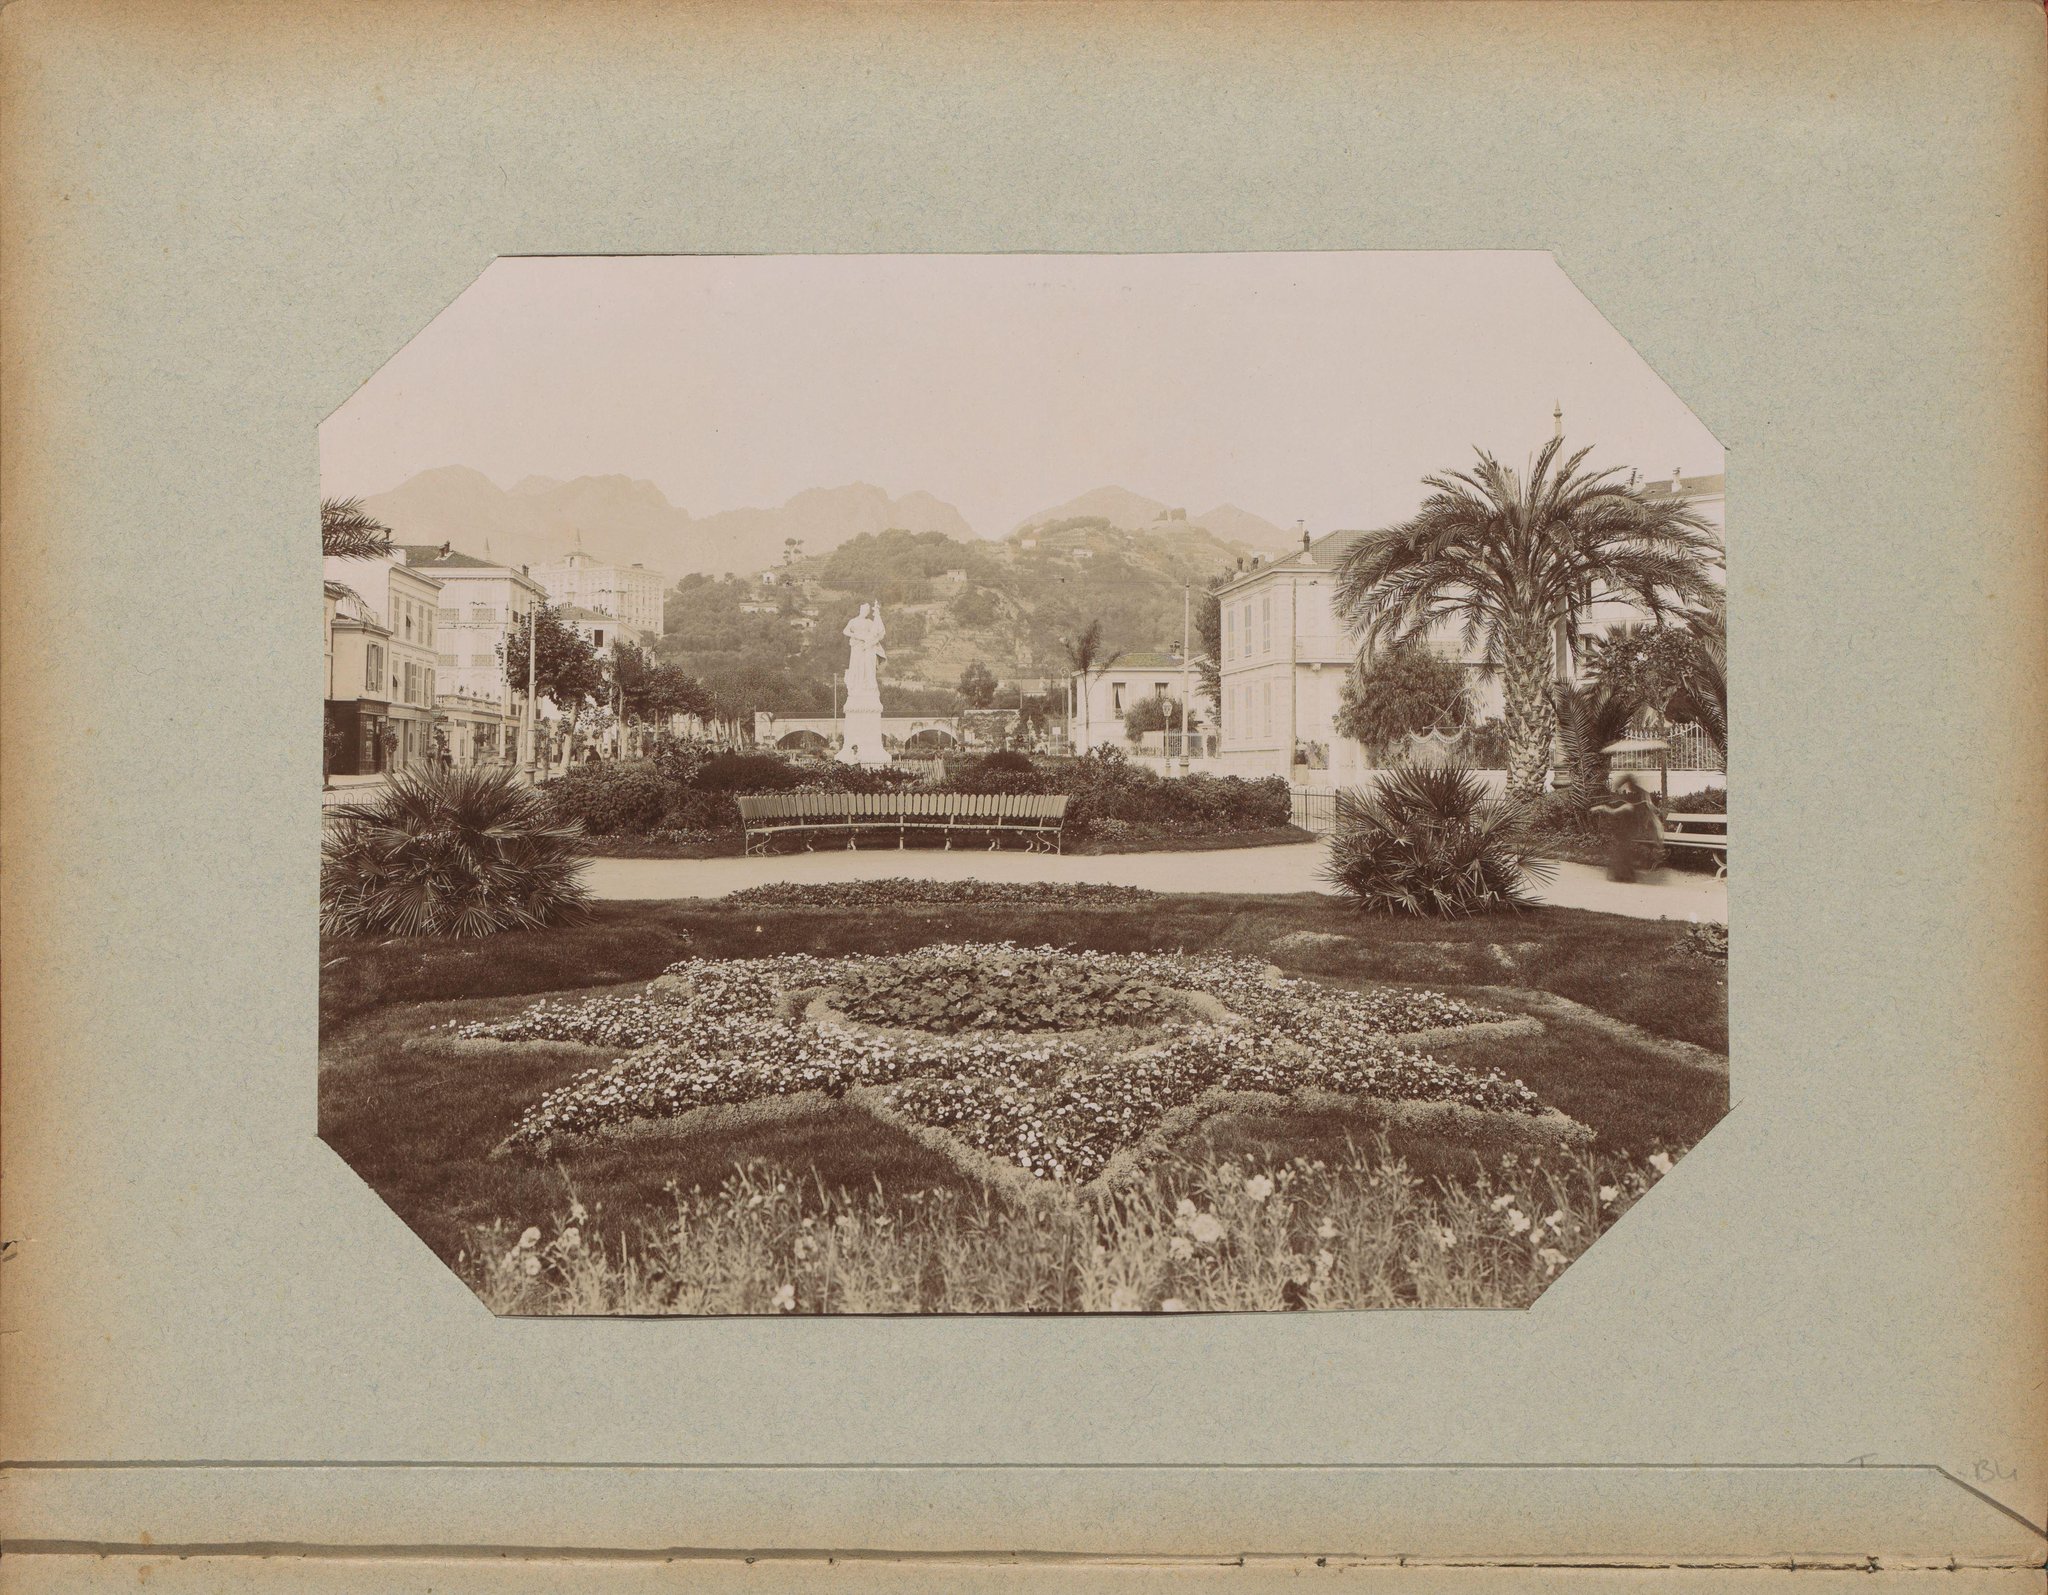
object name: album leaf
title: Plantsoen (thans Avenue de Verdun) in Menton met een standbeeld ter herdenking van de aansluiting bij Frankrijk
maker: Anonymous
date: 1880-1910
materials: paper, photographic support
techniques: daylight paper print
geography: menton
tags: monument, statue, public gardens, park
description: Onderdeel van Reisalbum met bezienswaardigheden in Engeland, Zwitserland, Frankrijk en Duitsland.